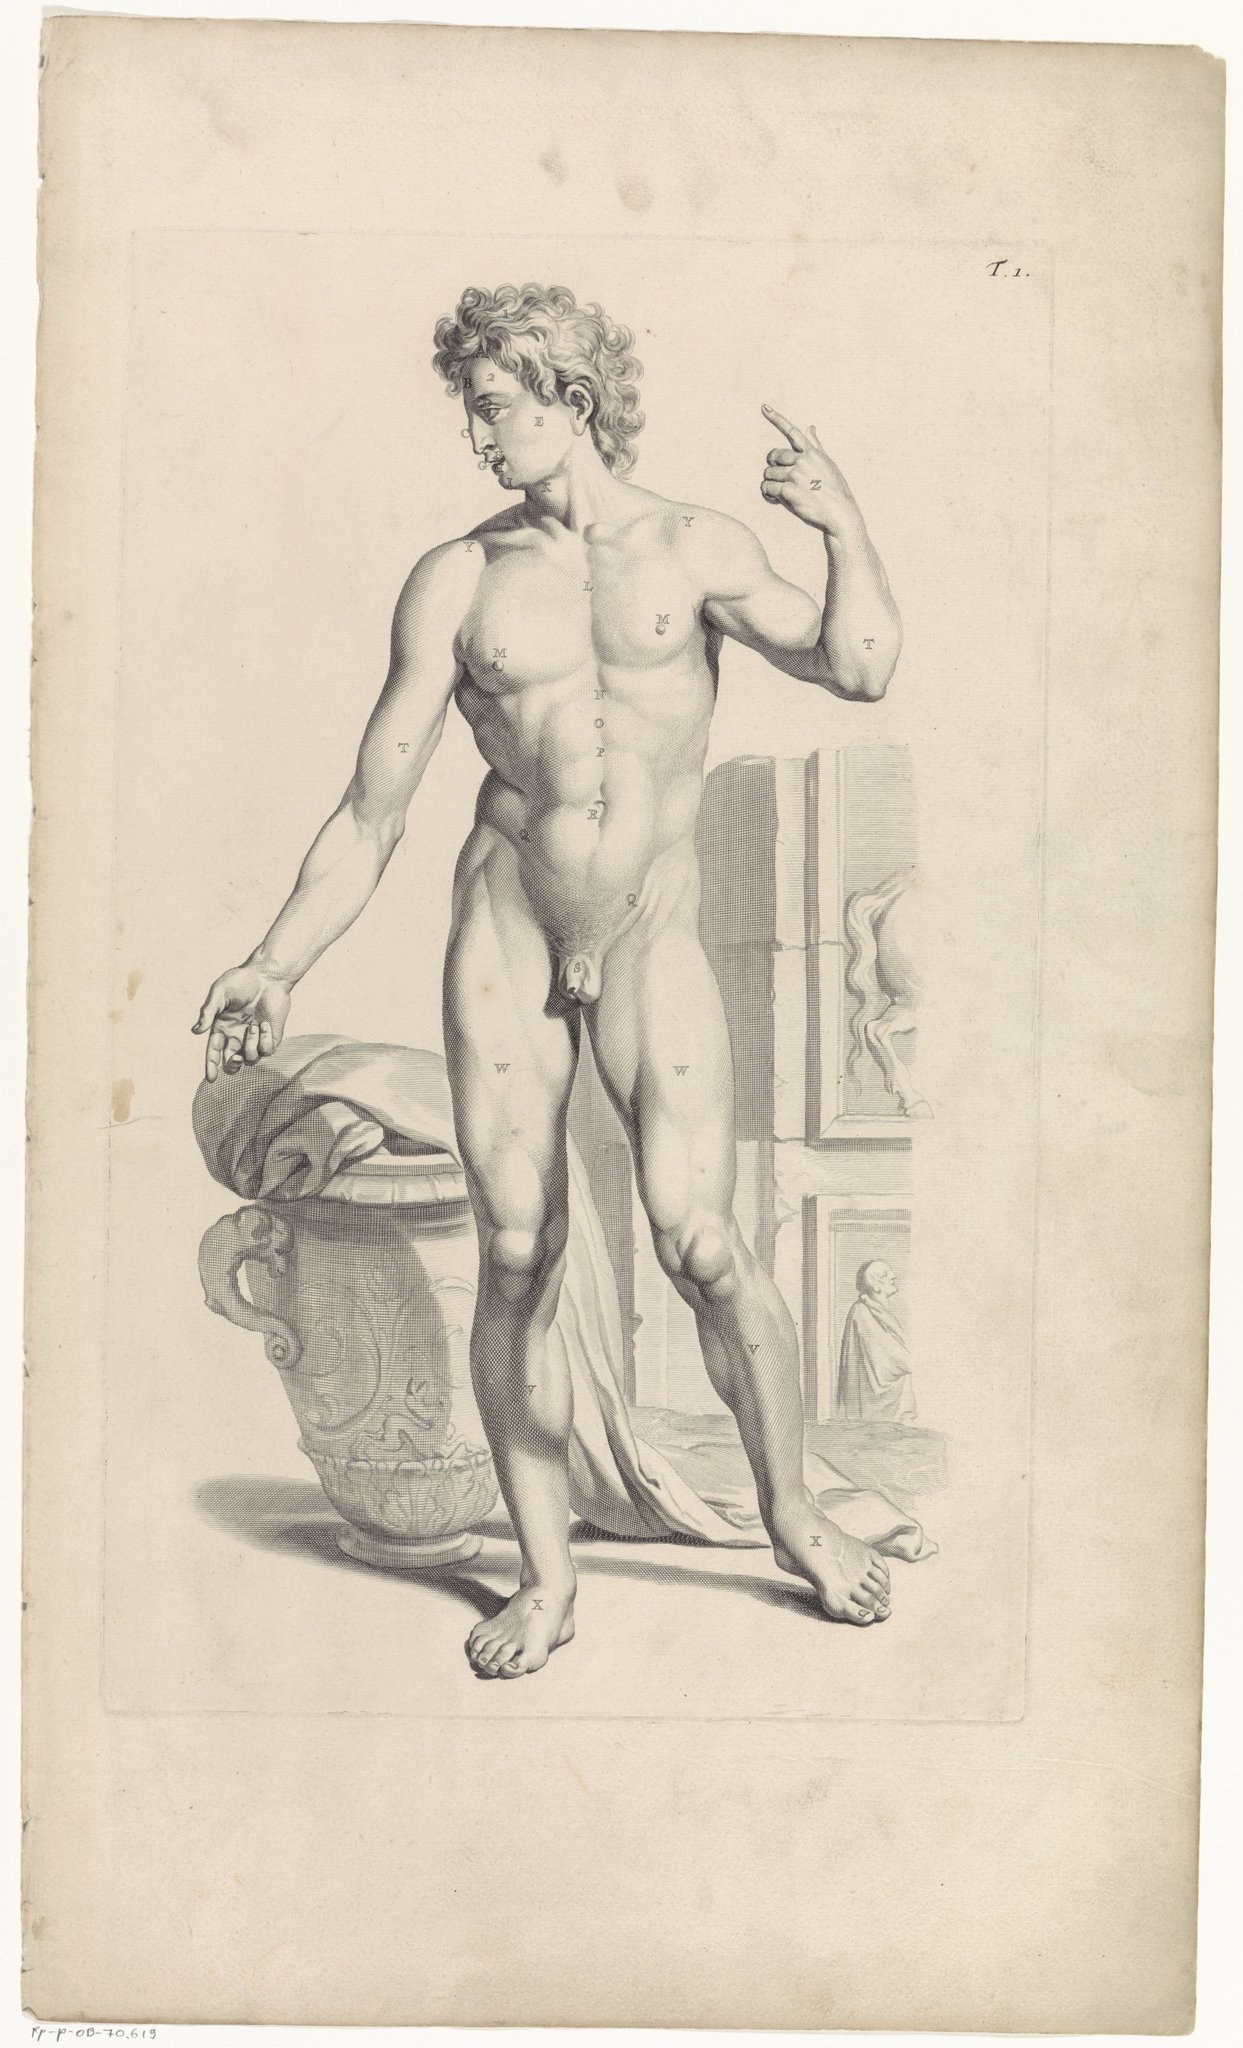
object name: print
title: Studie van het mannelijk naakt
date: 1685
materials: paper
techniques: engraving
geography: amsterdam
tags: human figure of ideal proportions, e.g. academic nude (+ front view)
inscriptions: collector's mark: Lugt 2228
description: Boekillustratie voor Bidloo, Godefridus. Anatomia humani corporis centum & quinque tabulis, per art. G. de Lairesse ad vivum delineatis, de monstrata, veterum recentiorumque inventis explicata plurimisque, hactenus non detectis, illustrata. Amsterdam: Weduwe Joannes van Someren, Hendrick Boom en erven Dirk Boom, 1685.